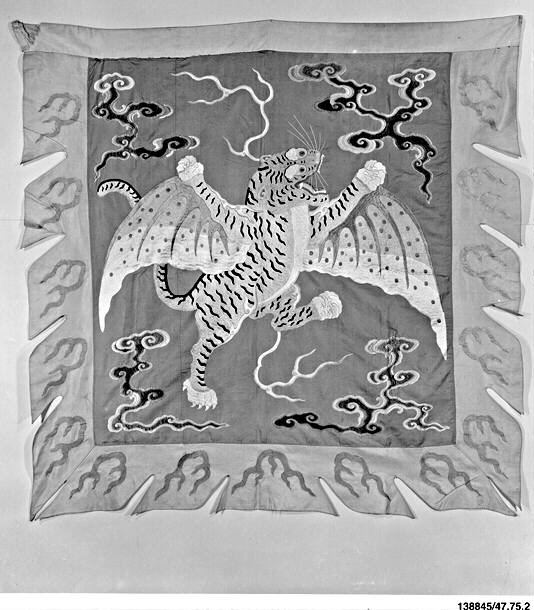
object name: banner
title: Banner (one of a pair)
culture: chinese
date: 1801-1900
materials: gold, silk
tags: flags